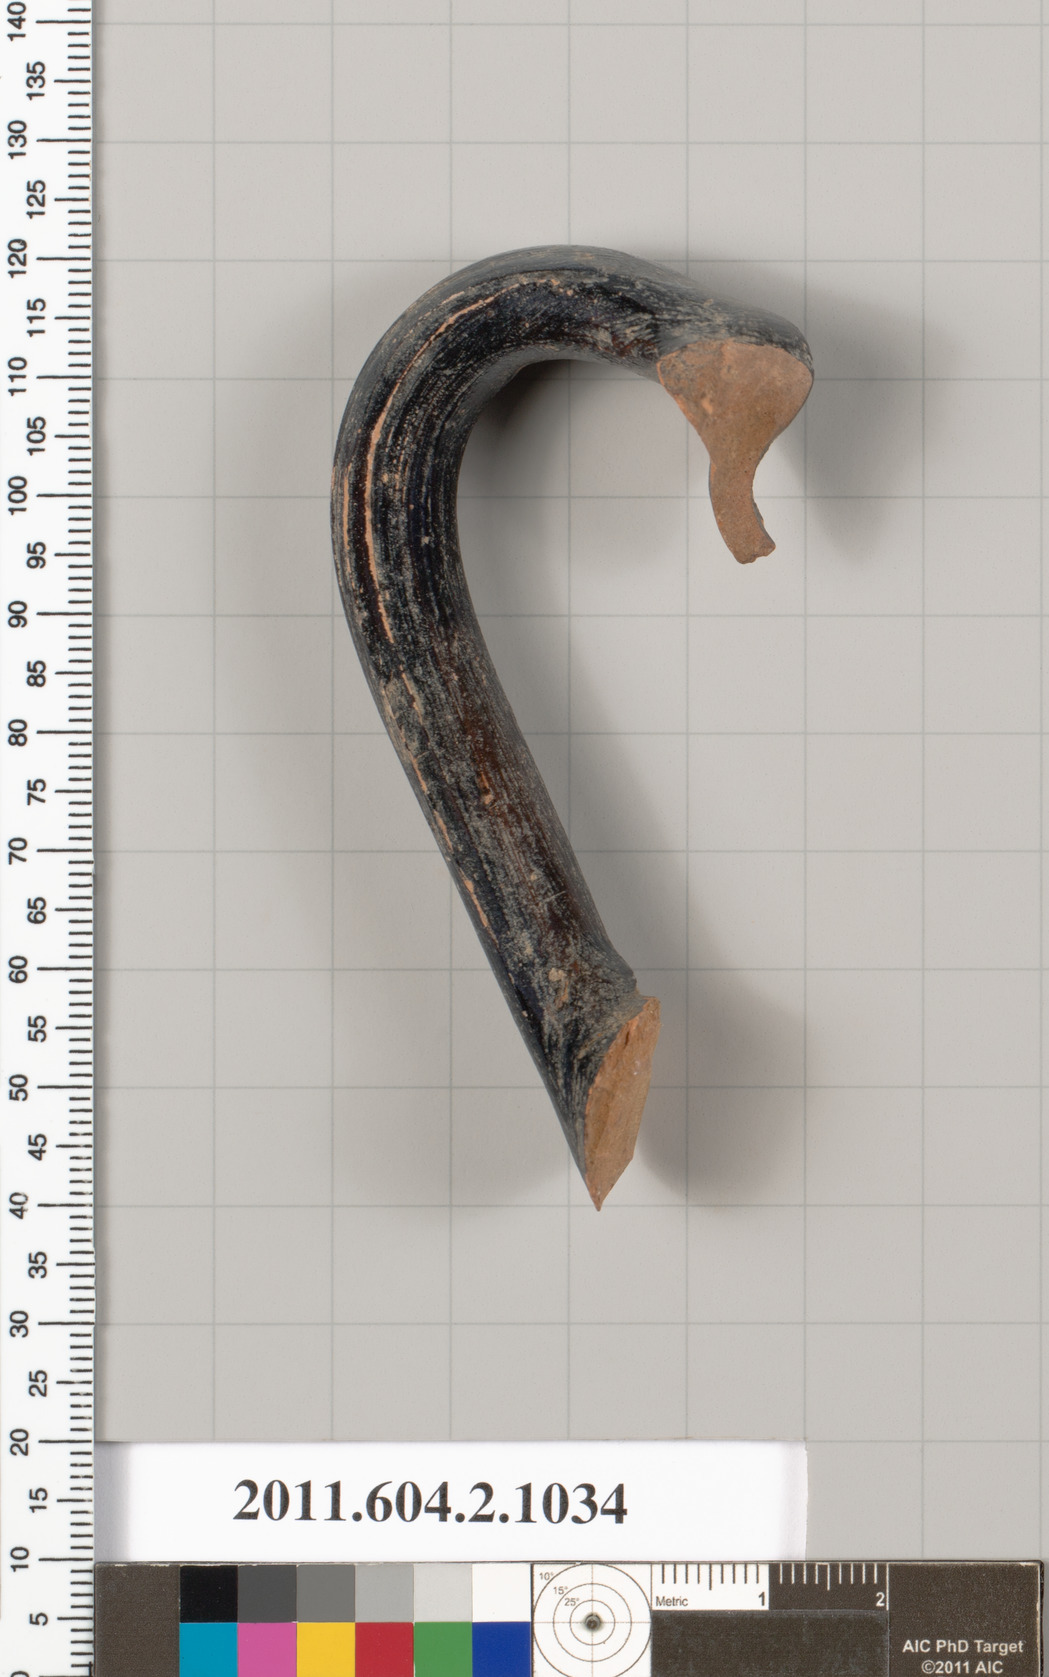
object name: oinochoe fragment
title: Terracotta fragment of an oinochoe (jug)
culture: greek, attic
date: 475-425 BCE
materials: terracotta